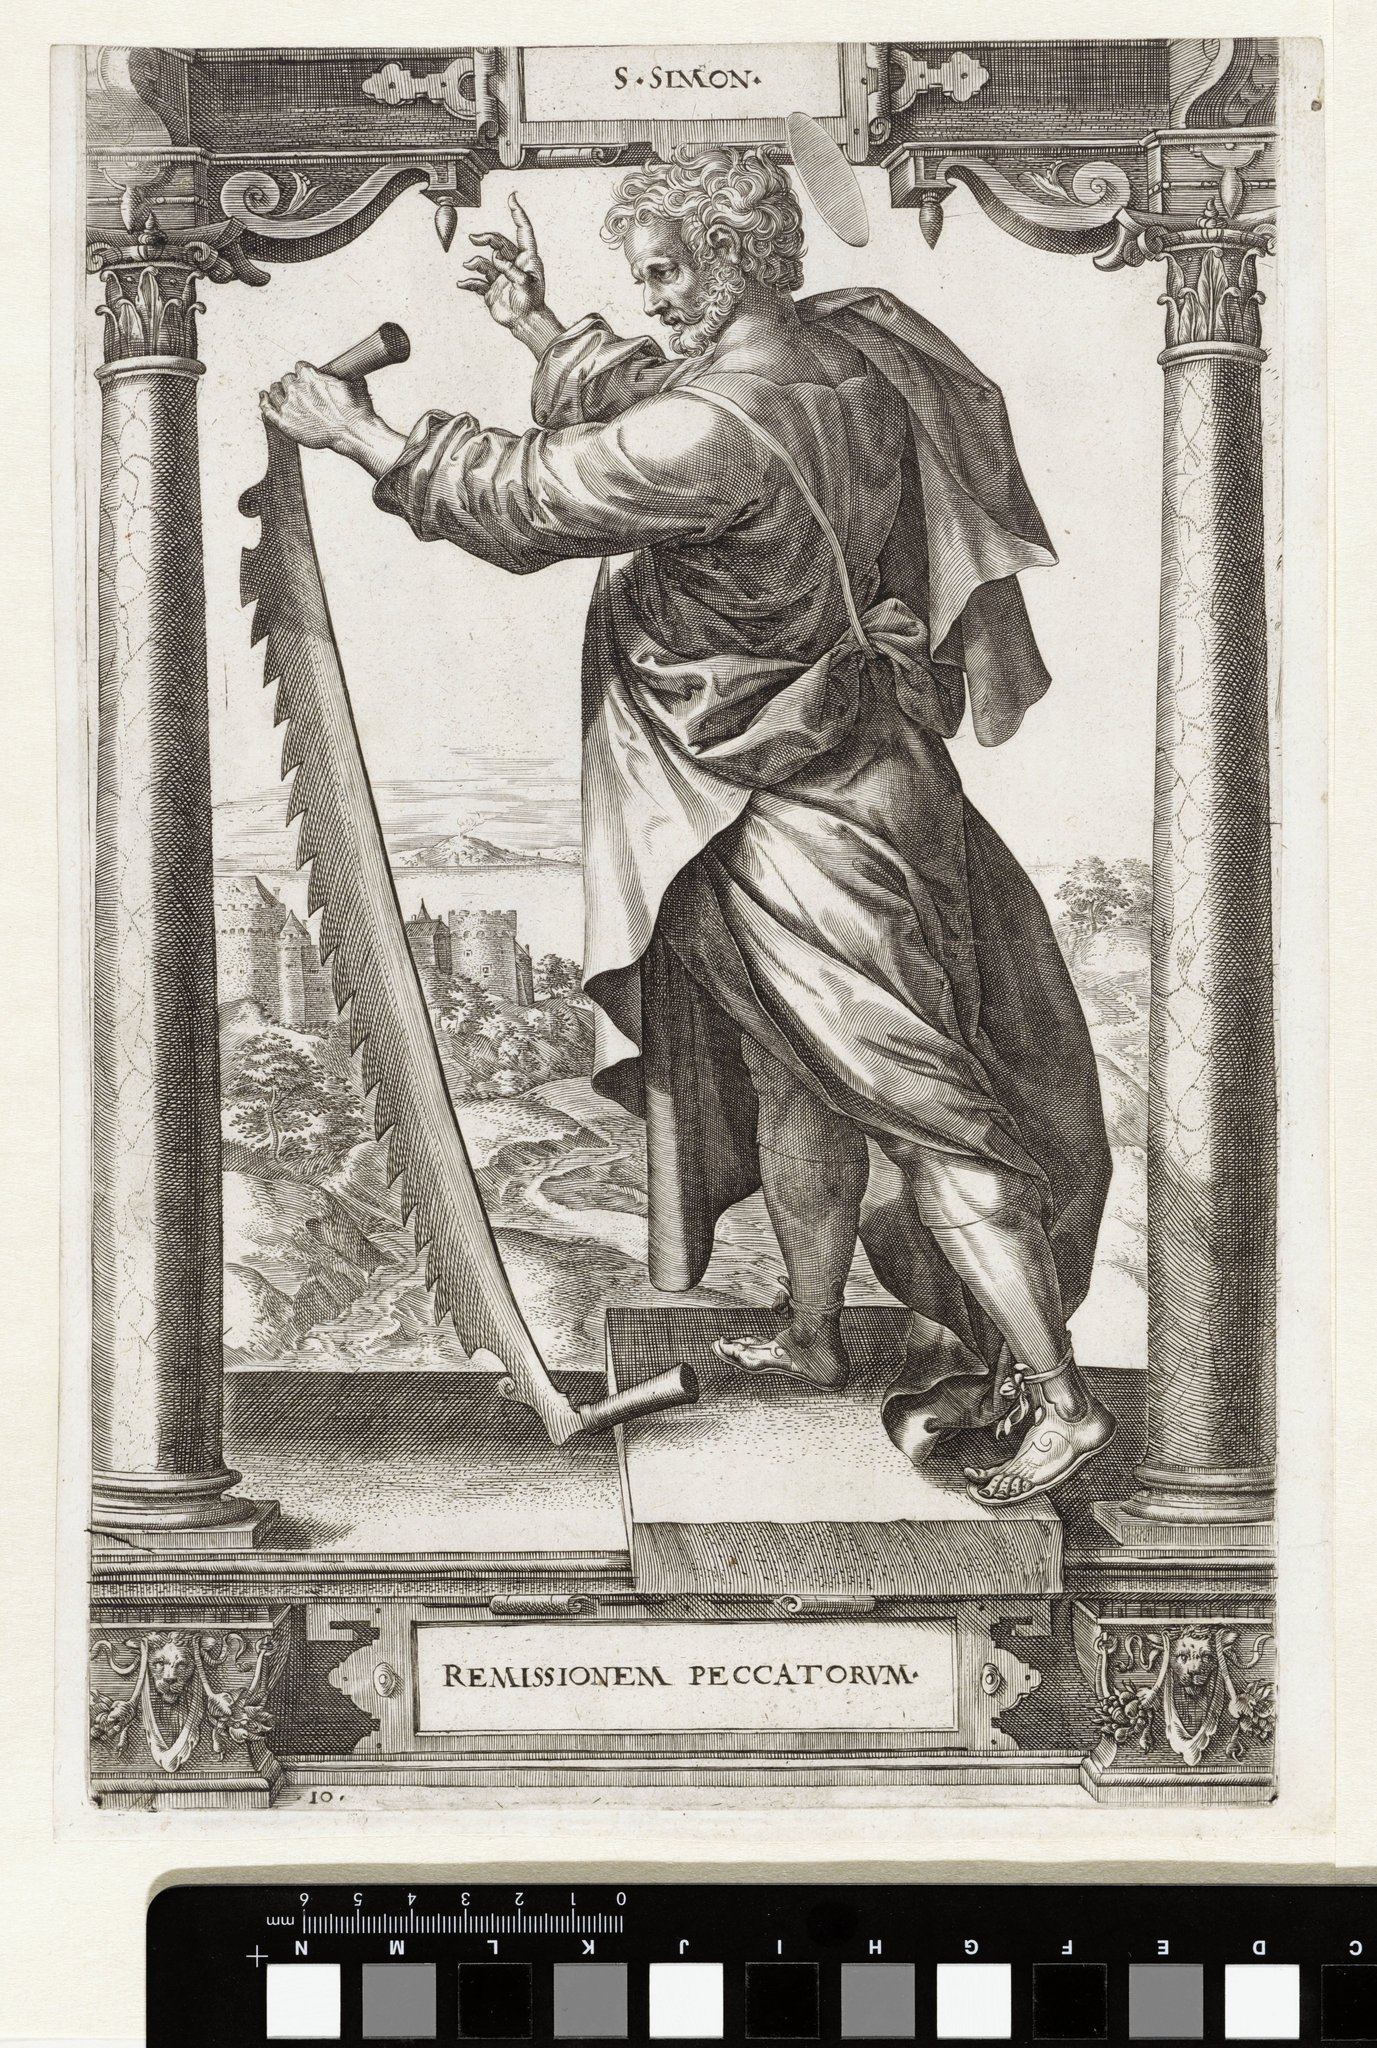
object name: print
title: H. Simon Zelotes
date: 1578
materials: paper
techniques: engraving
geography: antwerp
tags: column, pillar ~ architecture, the apostle simon zelotes (or simon the canaanite); possible attributes: book, saw, scroll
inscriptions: collector's mark: Lugt 2228, collector's mark: Lugt 2760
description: De heilige Simon Zelotes staat, op de rug gezien, tussen twee zuilen in een architecturale omlijsting. In zijn hand houdt hij een zaag. Op de achtergrond een gezicht op een heuvelachtig landschap. In het kader onderaan een onderschrift in het Latijn.